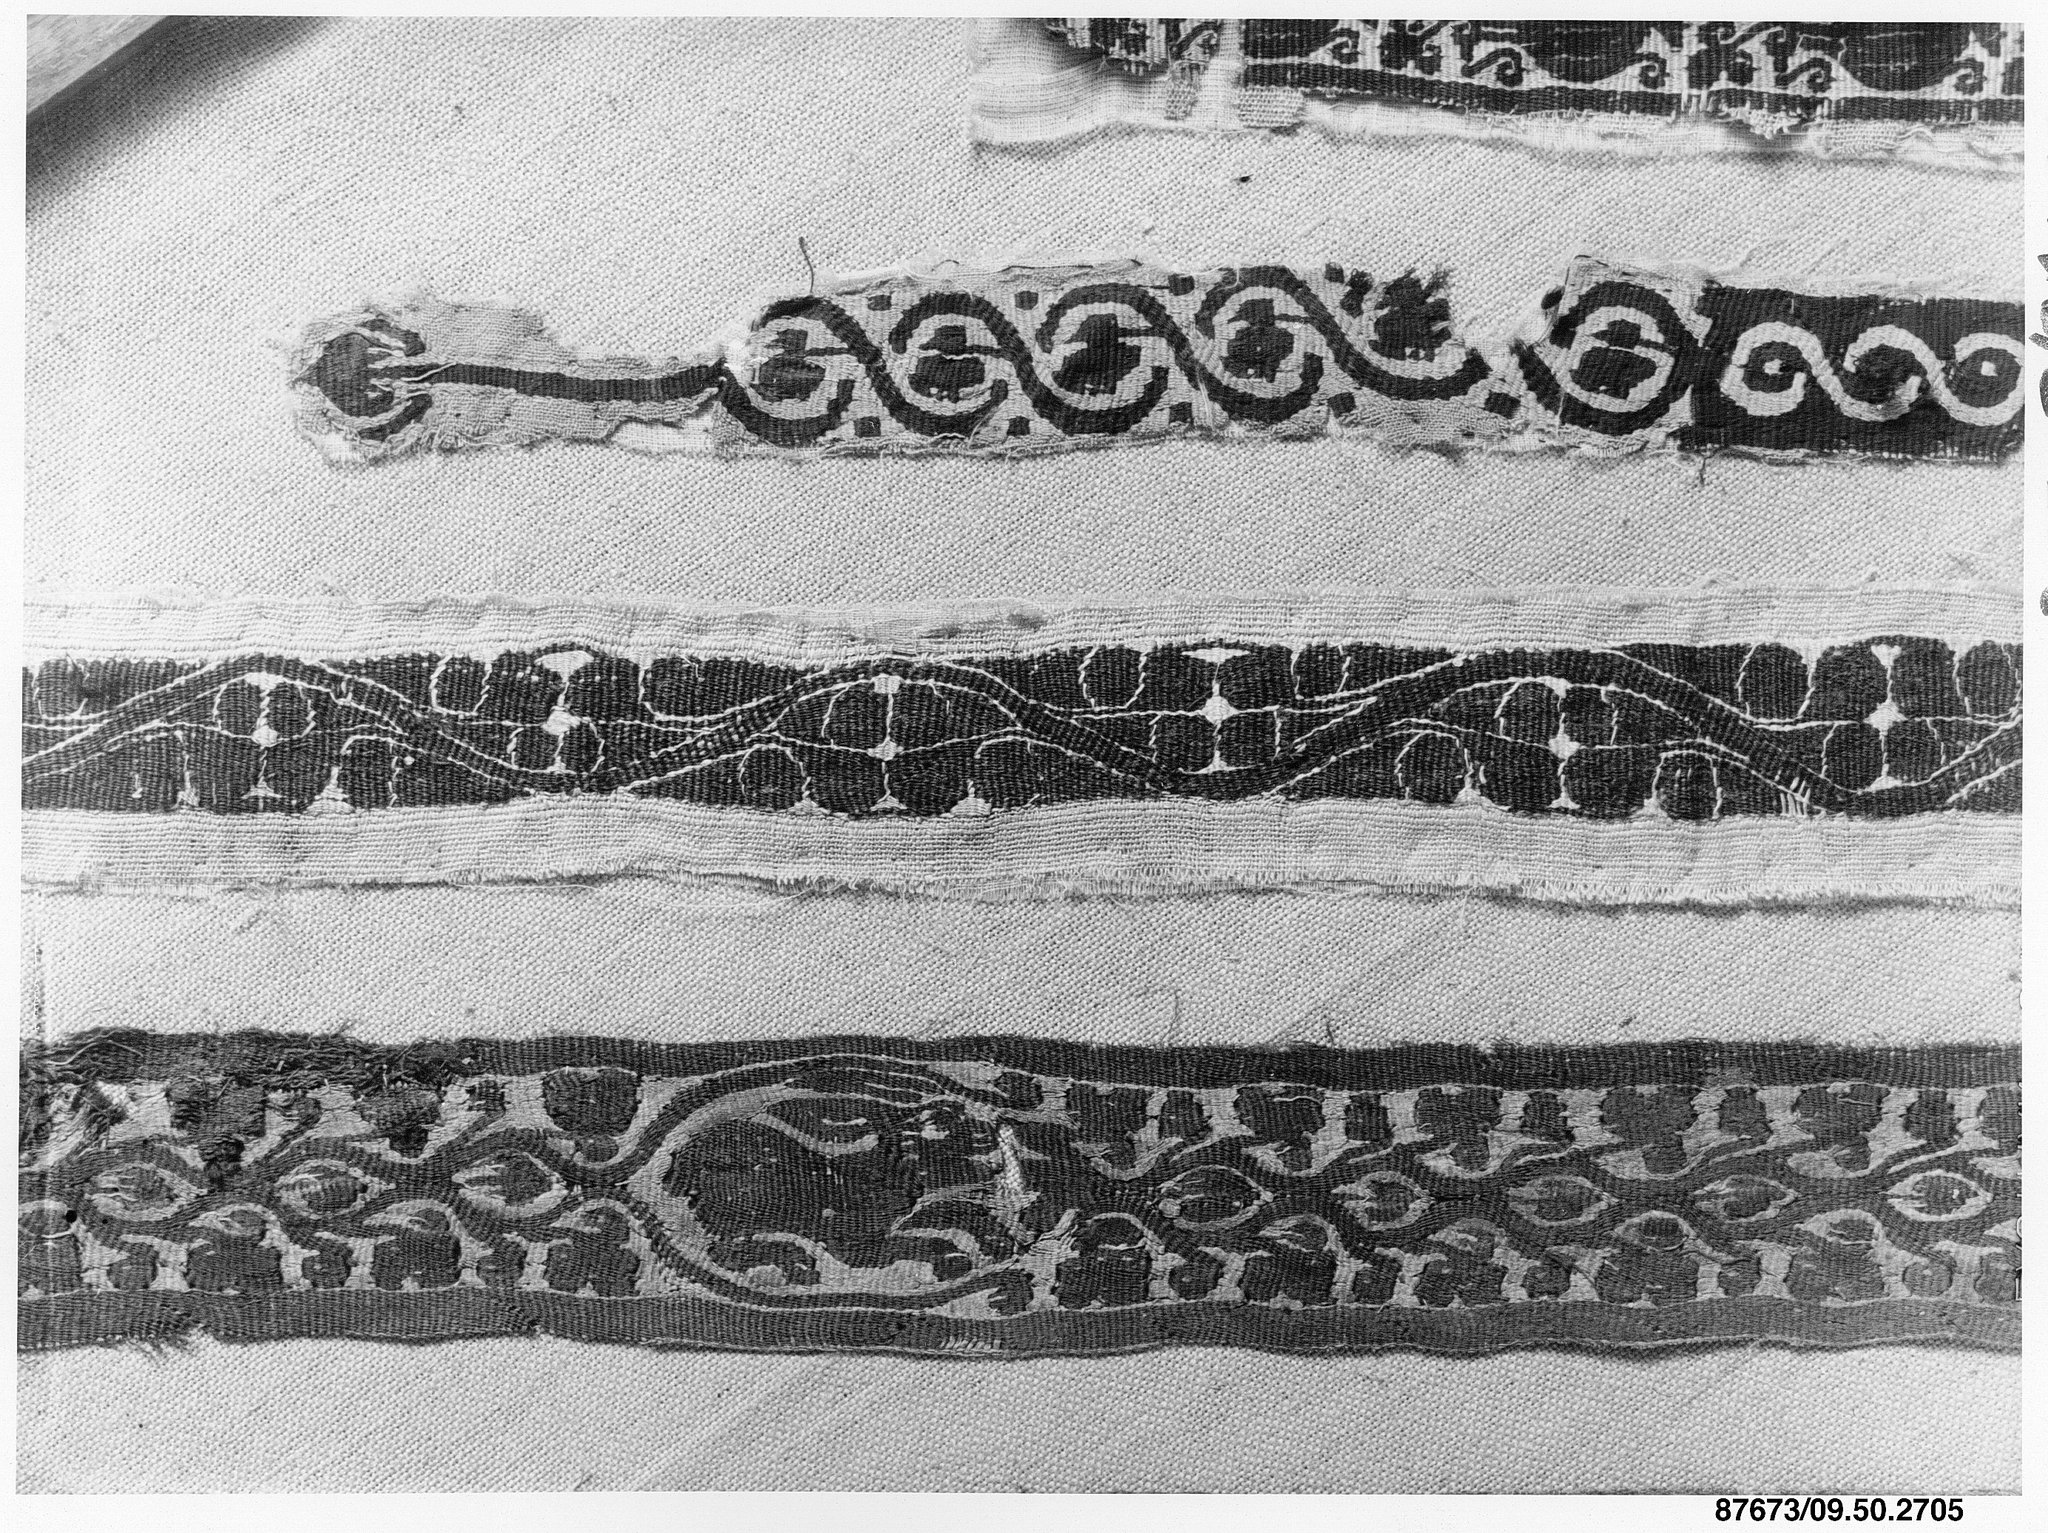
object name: band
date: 201-400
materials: linen, wool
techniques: weave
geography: egypt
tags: rabbits